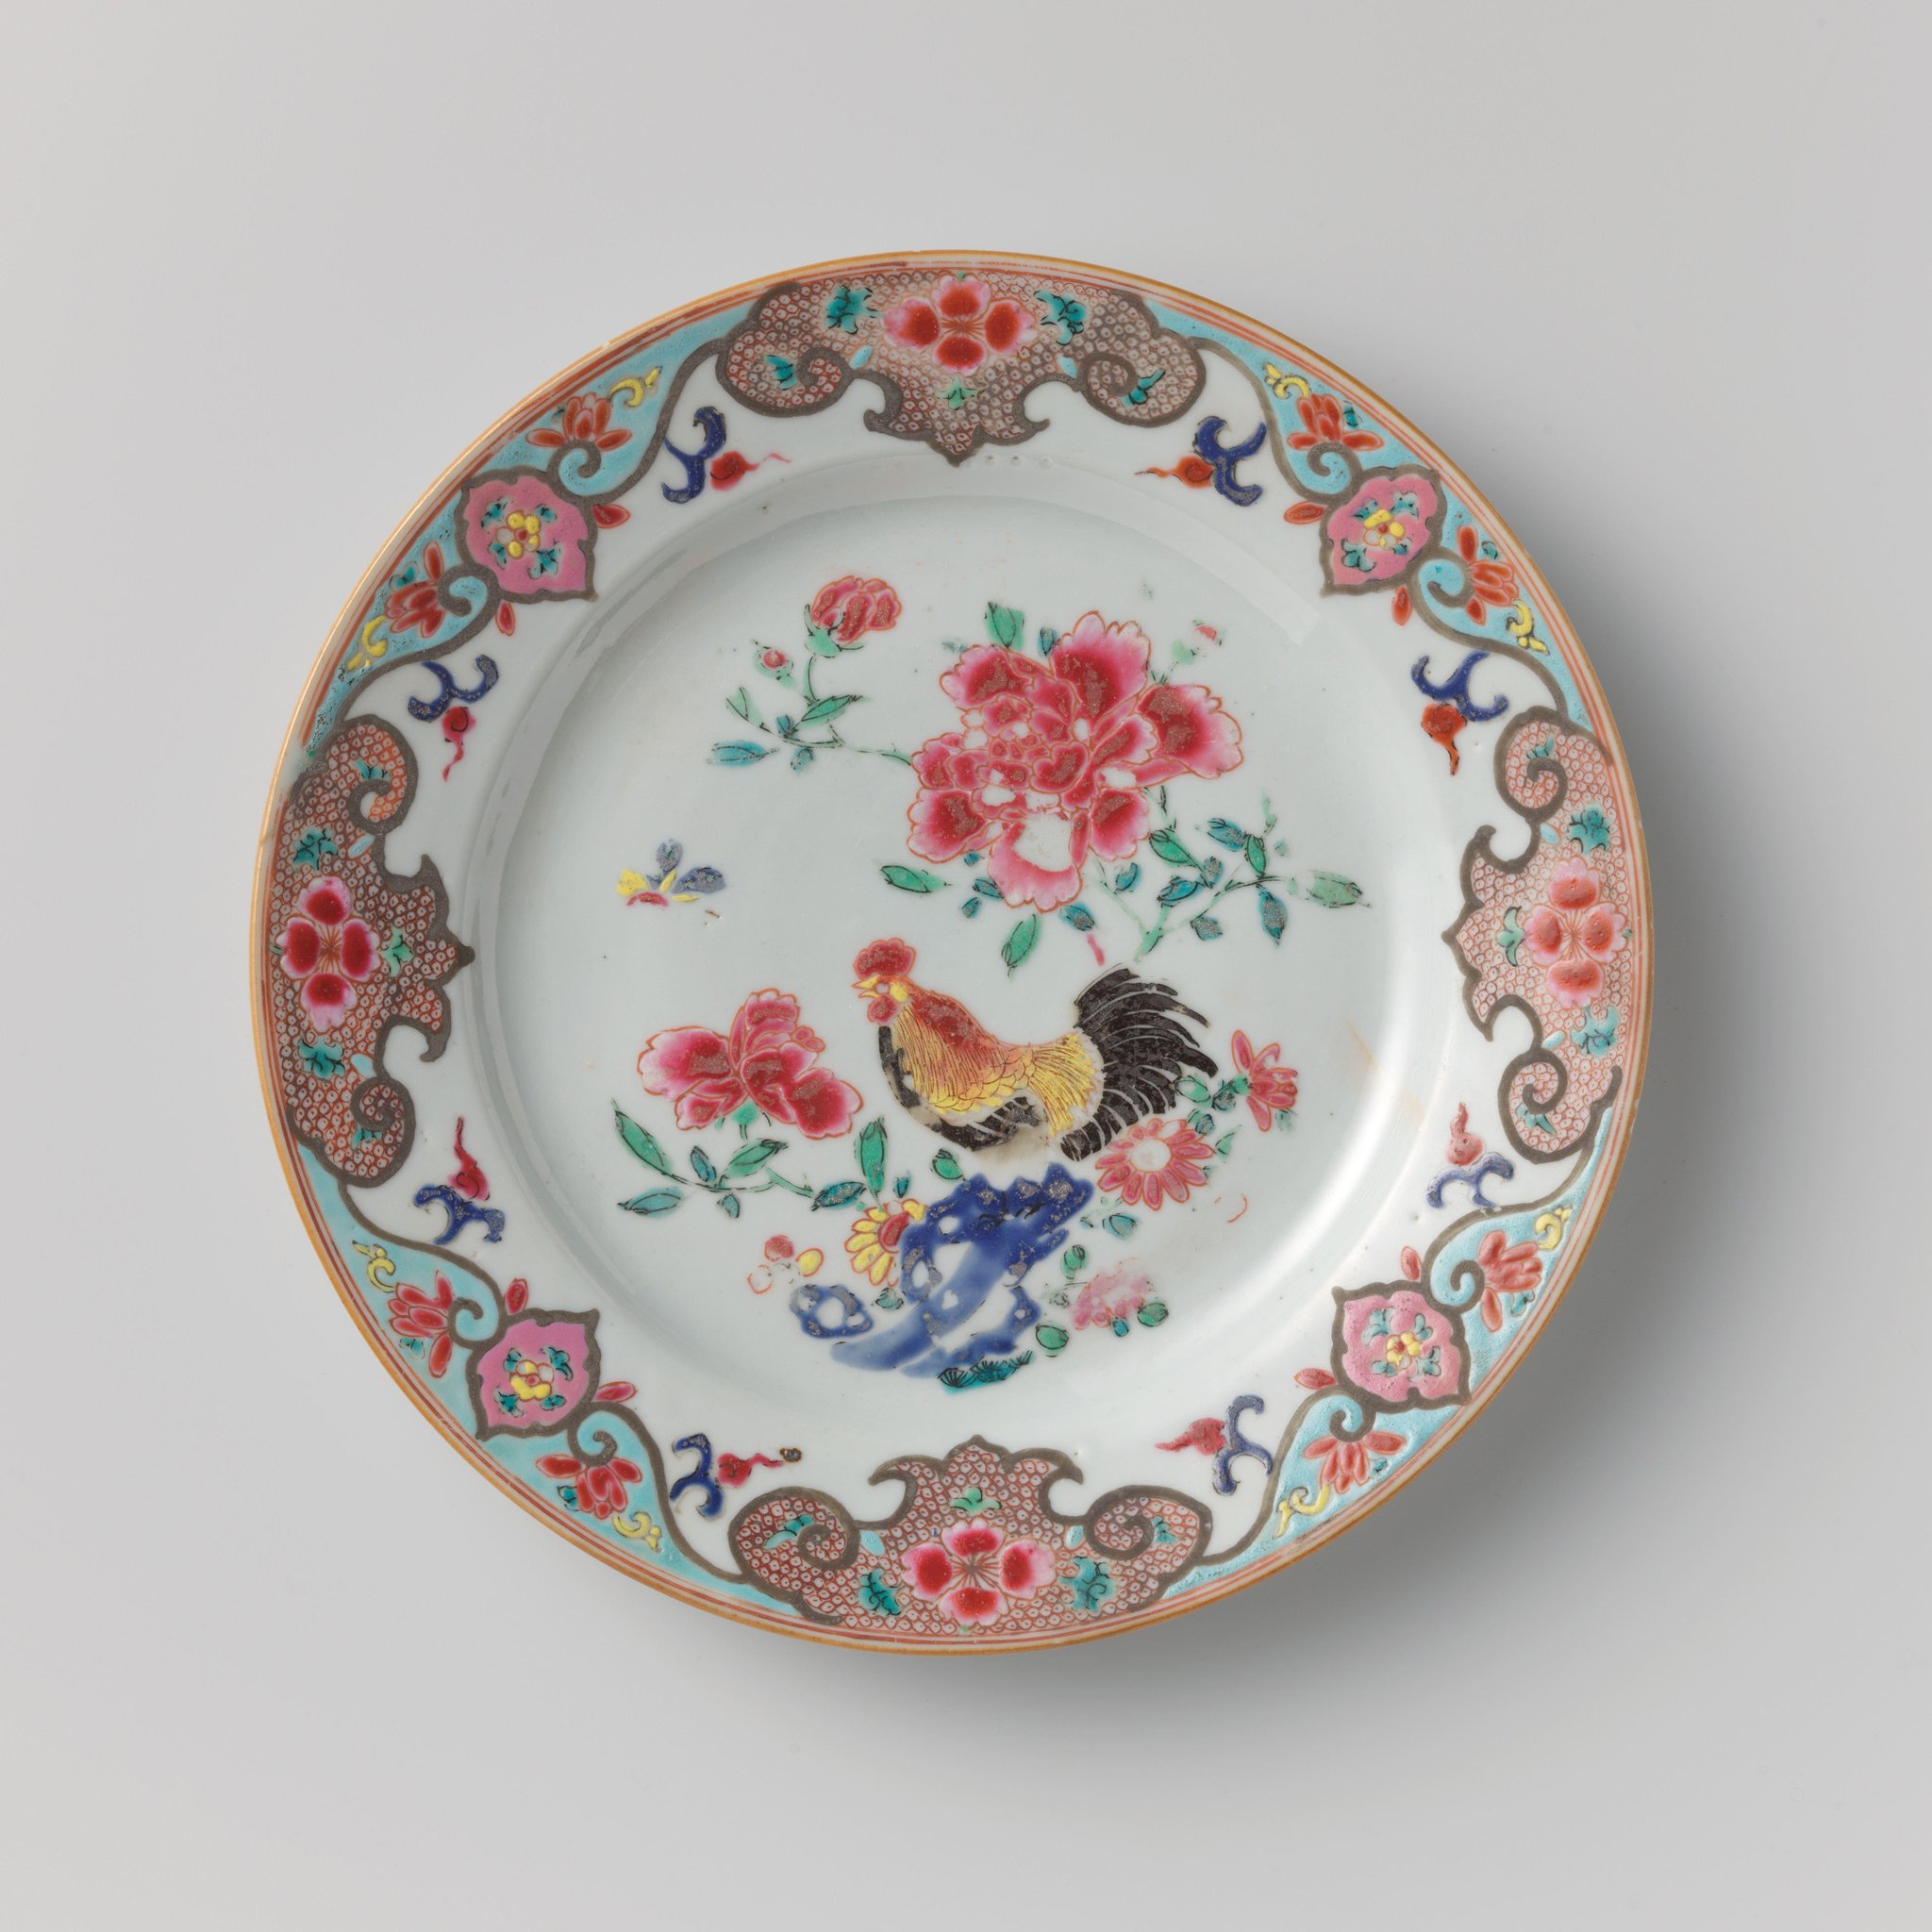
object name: plate dish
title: Plate with a cock on a rock near flowering plants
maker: Anonymous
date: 1800-1899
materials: glaze, paint, porcelain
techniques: firing, turning, vitrification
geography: china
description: Bord van porselein, beschilderd op het glazuur in blauw, rood, roze, groen, geel en zwart. Op het plat een haan op een rots bij bloeiende planten (pioen, aster) en een vlinder; op de rand een decoratieve band met krulwerk, servetwerk, bloemtakken en gestileerde lotusranken. Famille rose.